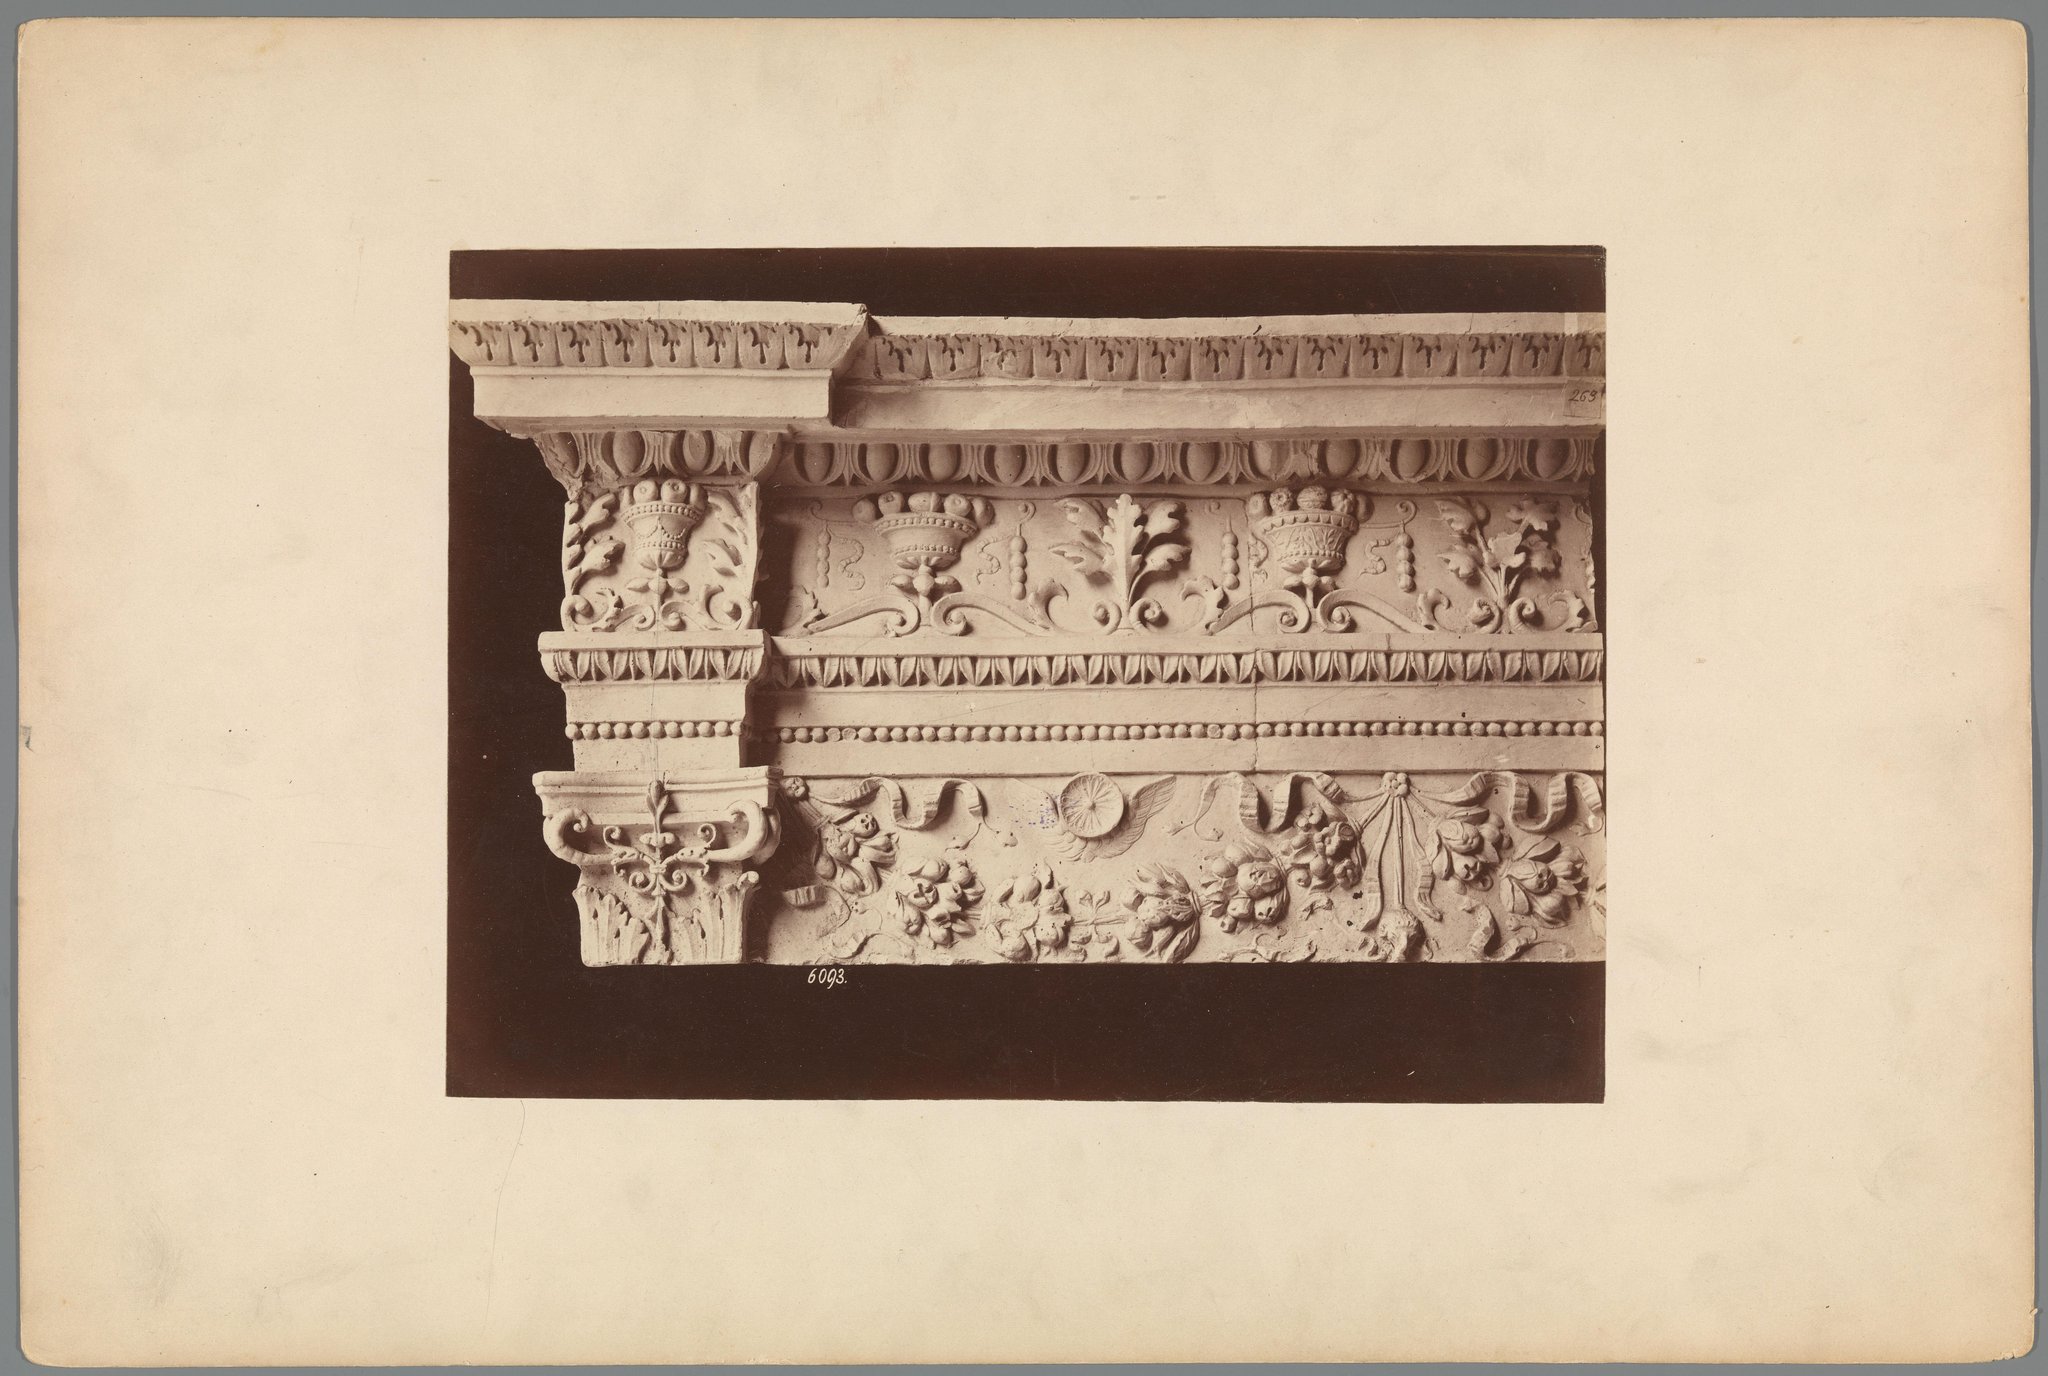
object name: photograph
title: Detail van een fries gedecoreerd met schalen met fruit en guirlandes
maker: Anonymous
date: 1875-1900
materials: cardboard, photographic support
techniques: albumen print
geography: europe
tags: fruits and vegetables ~ ornament, vase ~ ornament, ornament ~ festoon, garland, europe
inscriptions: number: ‘6093.’, collector's mark: Lugt 3937